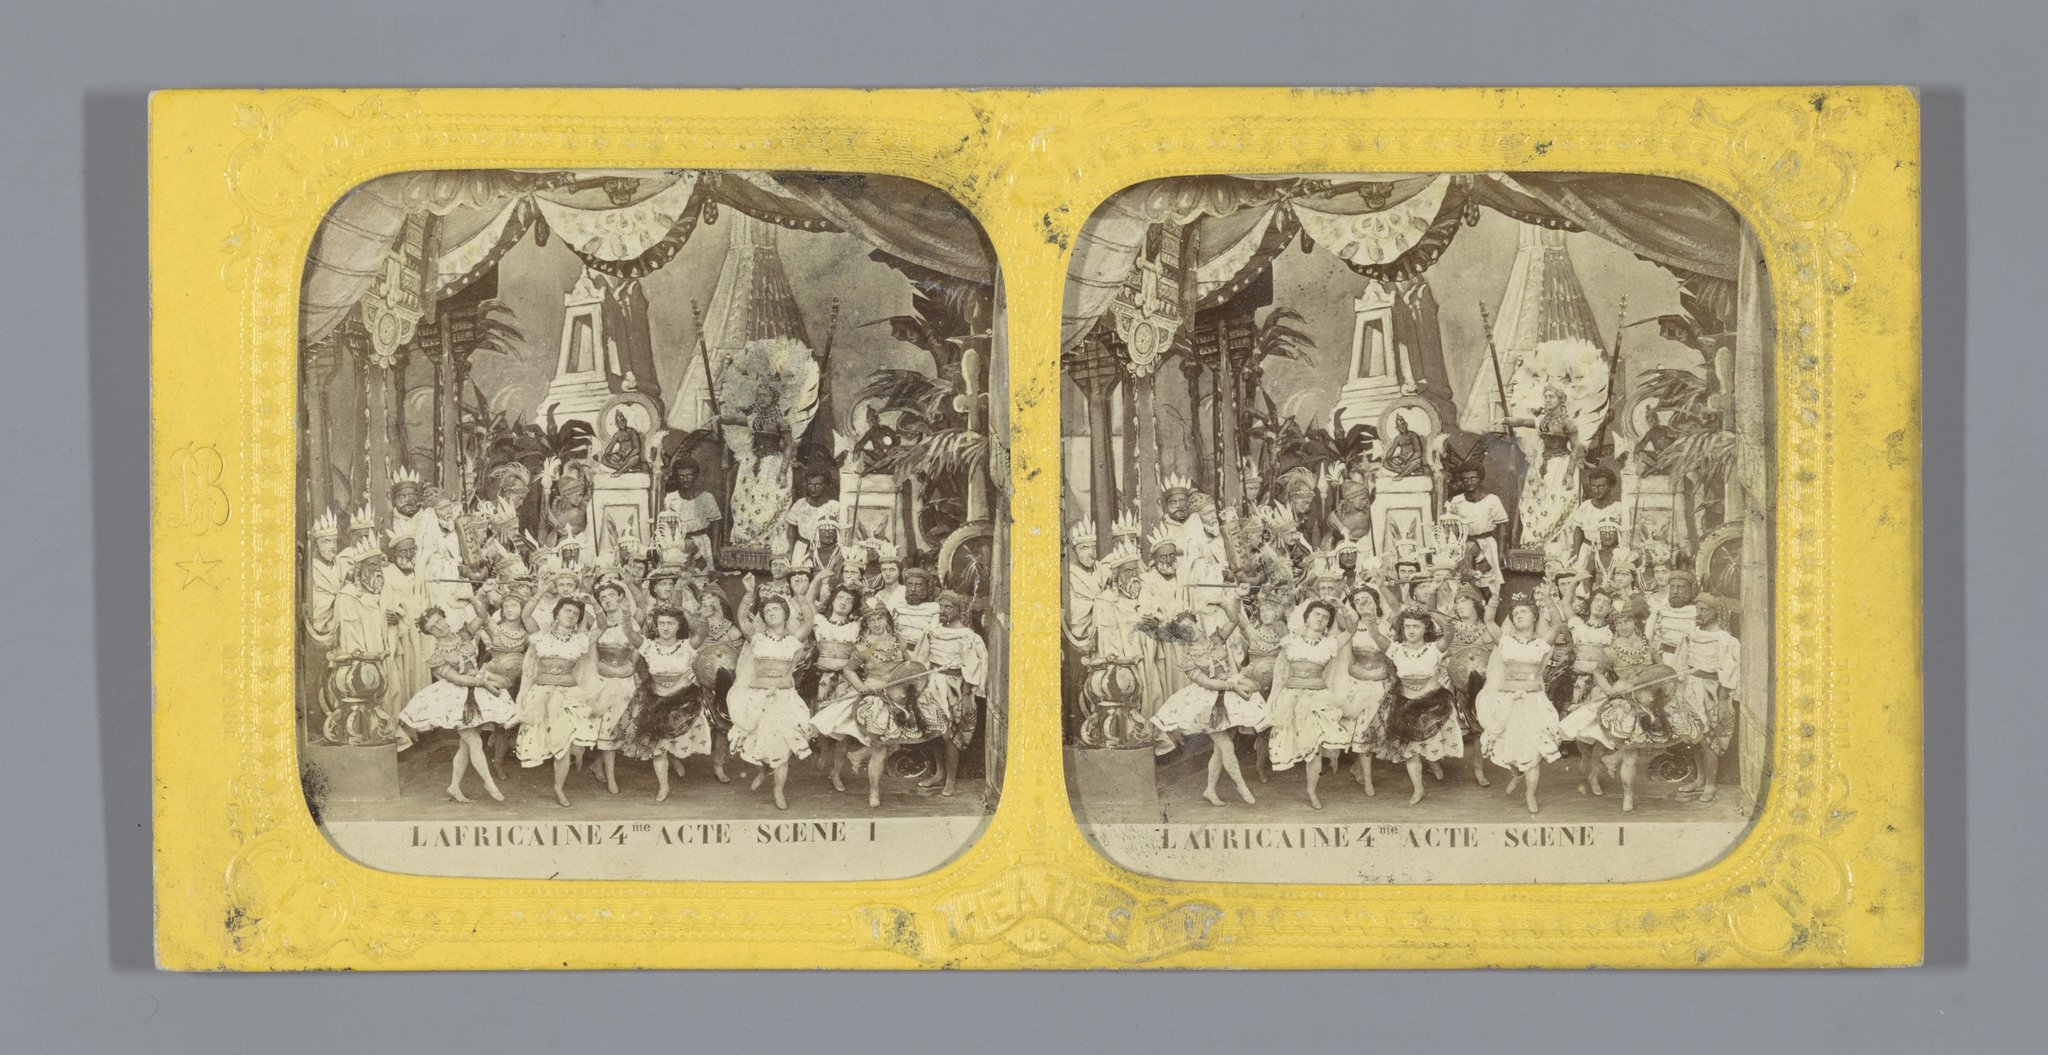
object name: tissue stereograph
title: Les theatres de Paris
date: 1873-1874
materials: cardboard, paper, photographic support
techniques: albumen print, cutting, hand coloring, perforating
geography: paris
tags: opera, paris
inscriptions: inscription: ‘DEPOSE’, inscription: ‘Toutes les epreuves non revêtues du timbre Les Théâtres de Paris/ et de ma marque De fabrique B. K. éditeur seront considérées/ comme contrefaçon, le dépôt ayant été fait en France selon la loi et à/ l' Etranger, conformement aux conventions internationales.’